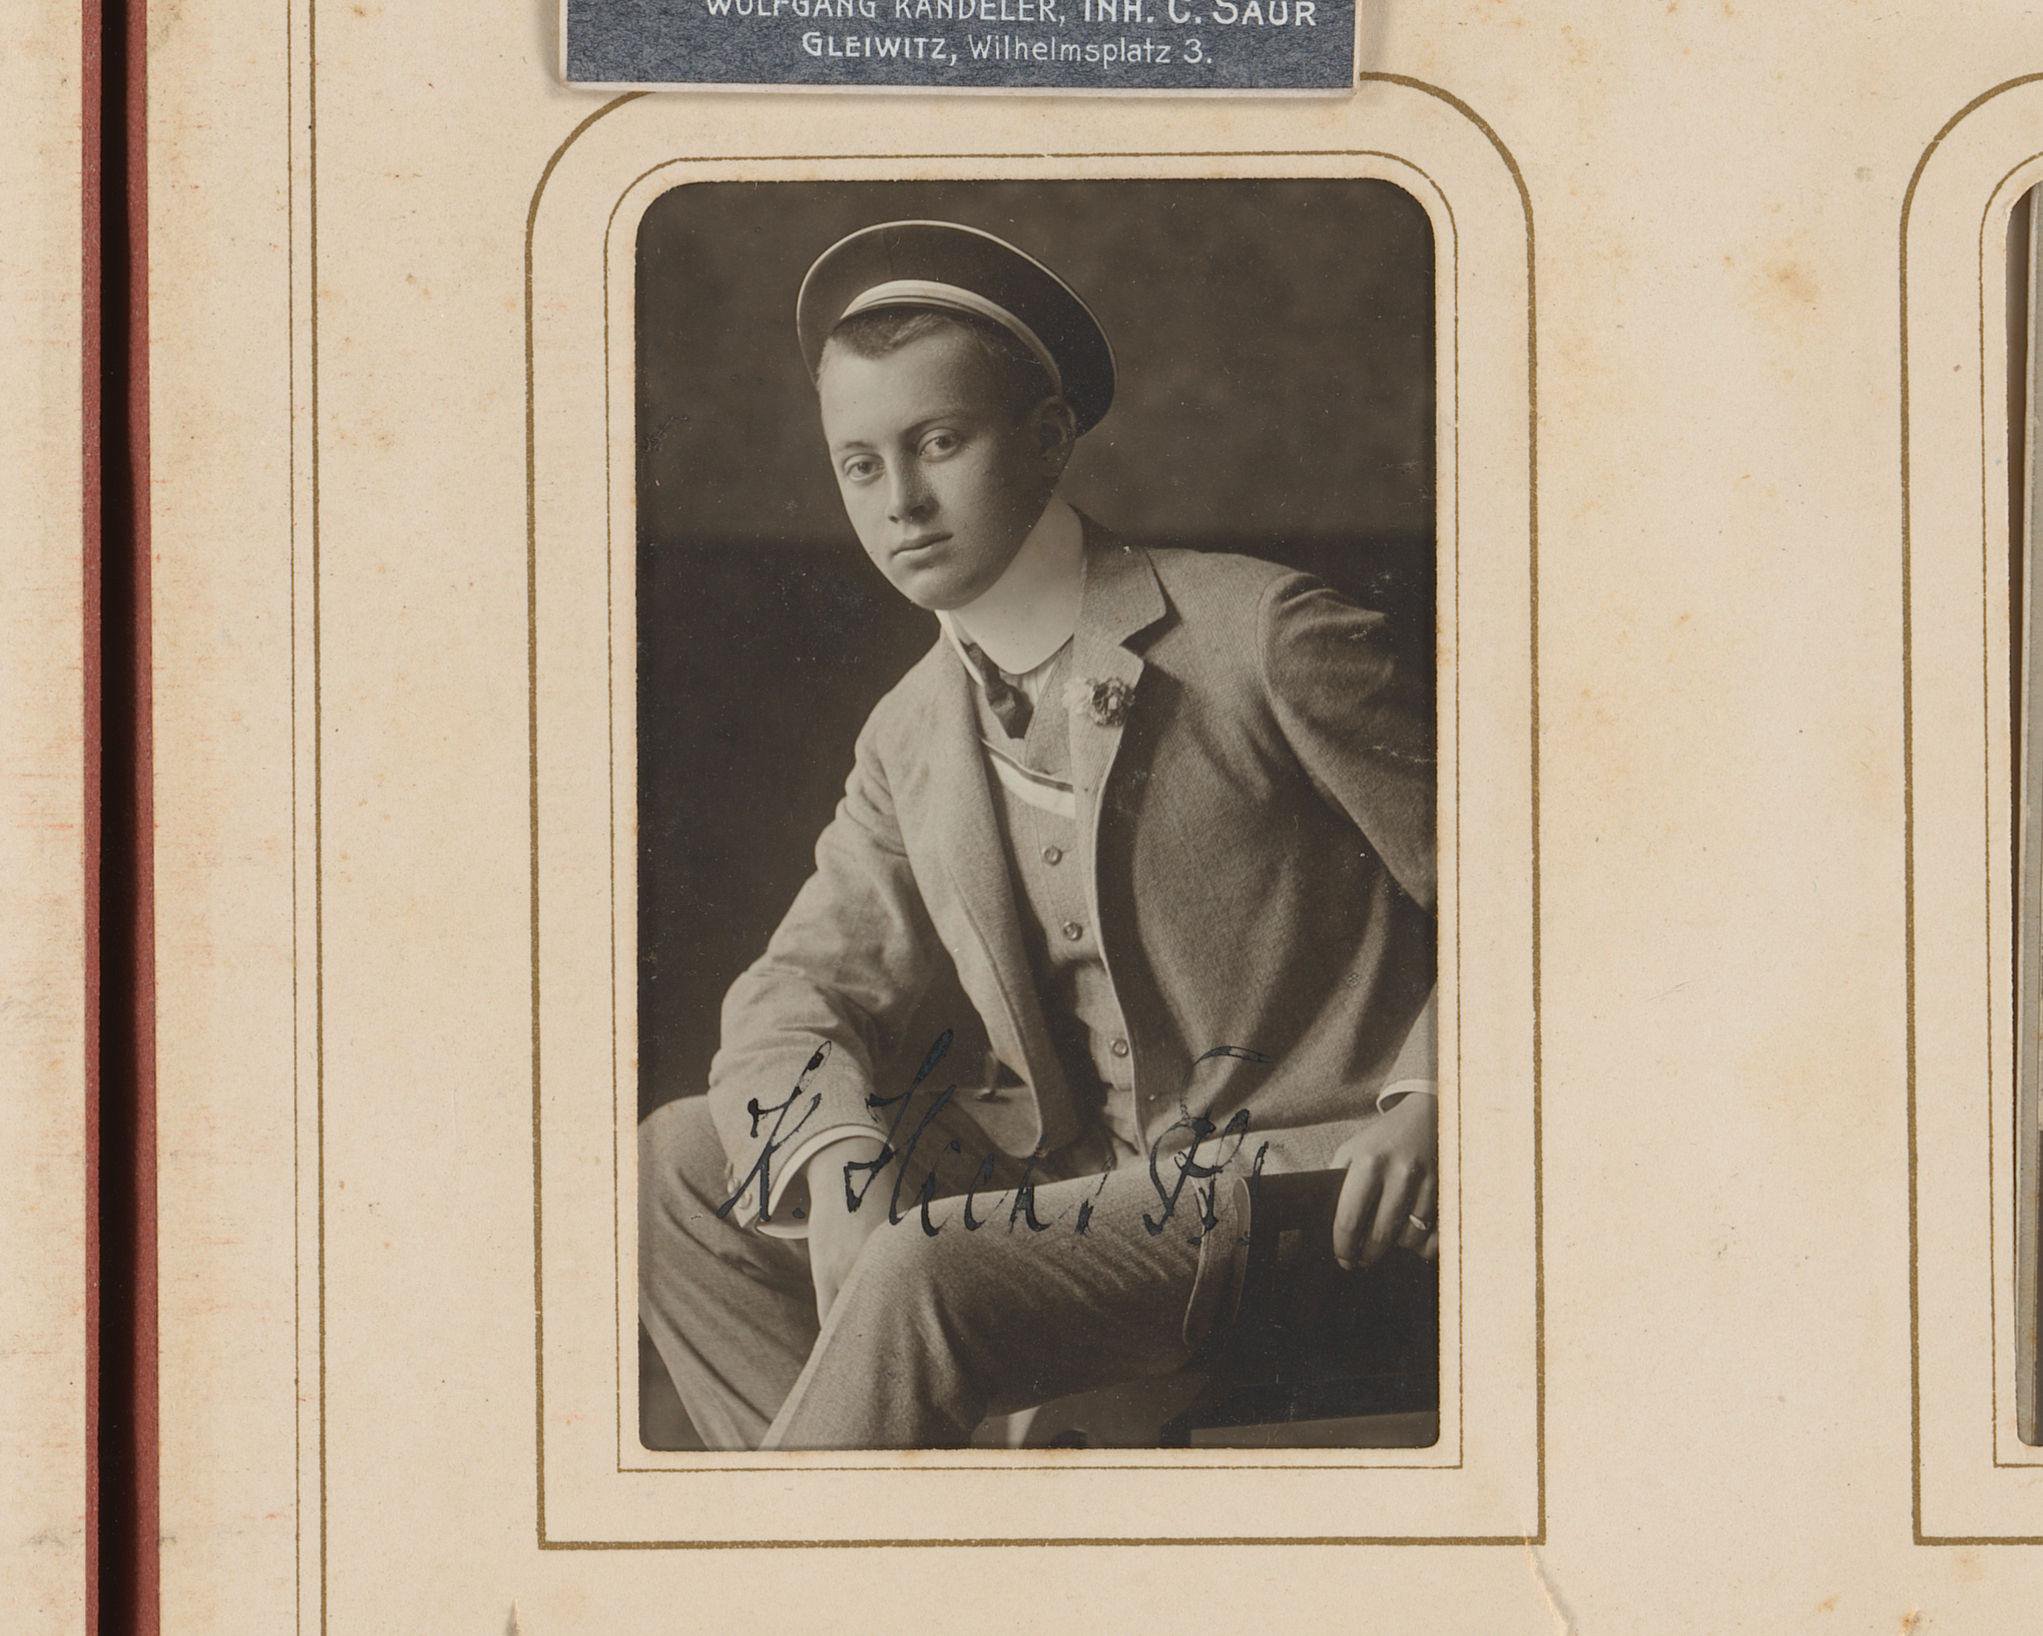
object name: carte de visite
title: Portret van een jonge man, aangeduid als K. Hecks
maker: franz grainer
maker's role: fotograaf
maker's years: 1871-1948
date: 1905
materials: cardboard, photographic support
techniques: matte daylight collodion silver print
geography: munich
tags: historical persons, youth, adolescent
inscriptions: inscription: ‘Moderne/ künstlerische fotografie/ Franz Grainer/ München/ Theatinerstr. 38/39 - Telefon 4341/ Besonderheit:/ Portrait-Aufnahmen in eigenen Heim./ Prämiirt:/ Turin 1901: höchtste Auszeichnung: Ehrendiplom/ u. Ehrenpreis,/ Mainz 1903: Goldene Medaille./ Die Platte bleibt aufbewahrt./ Vergrösserungen nach jedem Bilde.’, annotation: ‘Carl 1905.’, name: ‘K. Hecks [..]’